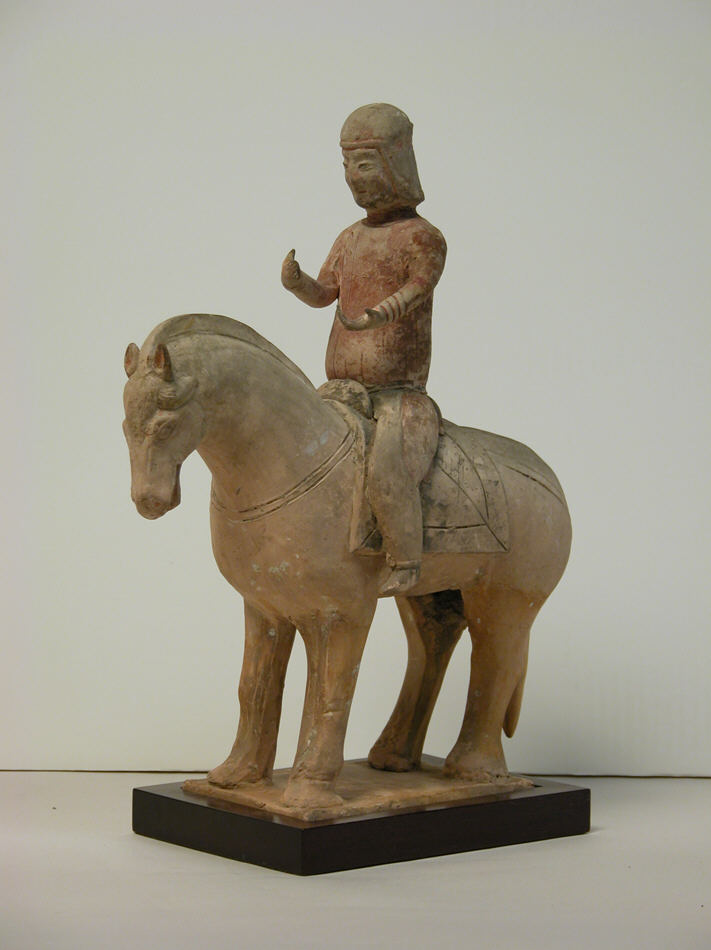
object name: figure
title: Mounted musician (one of two)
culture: chinese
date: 401-500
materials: earthenware, pigment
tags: horses